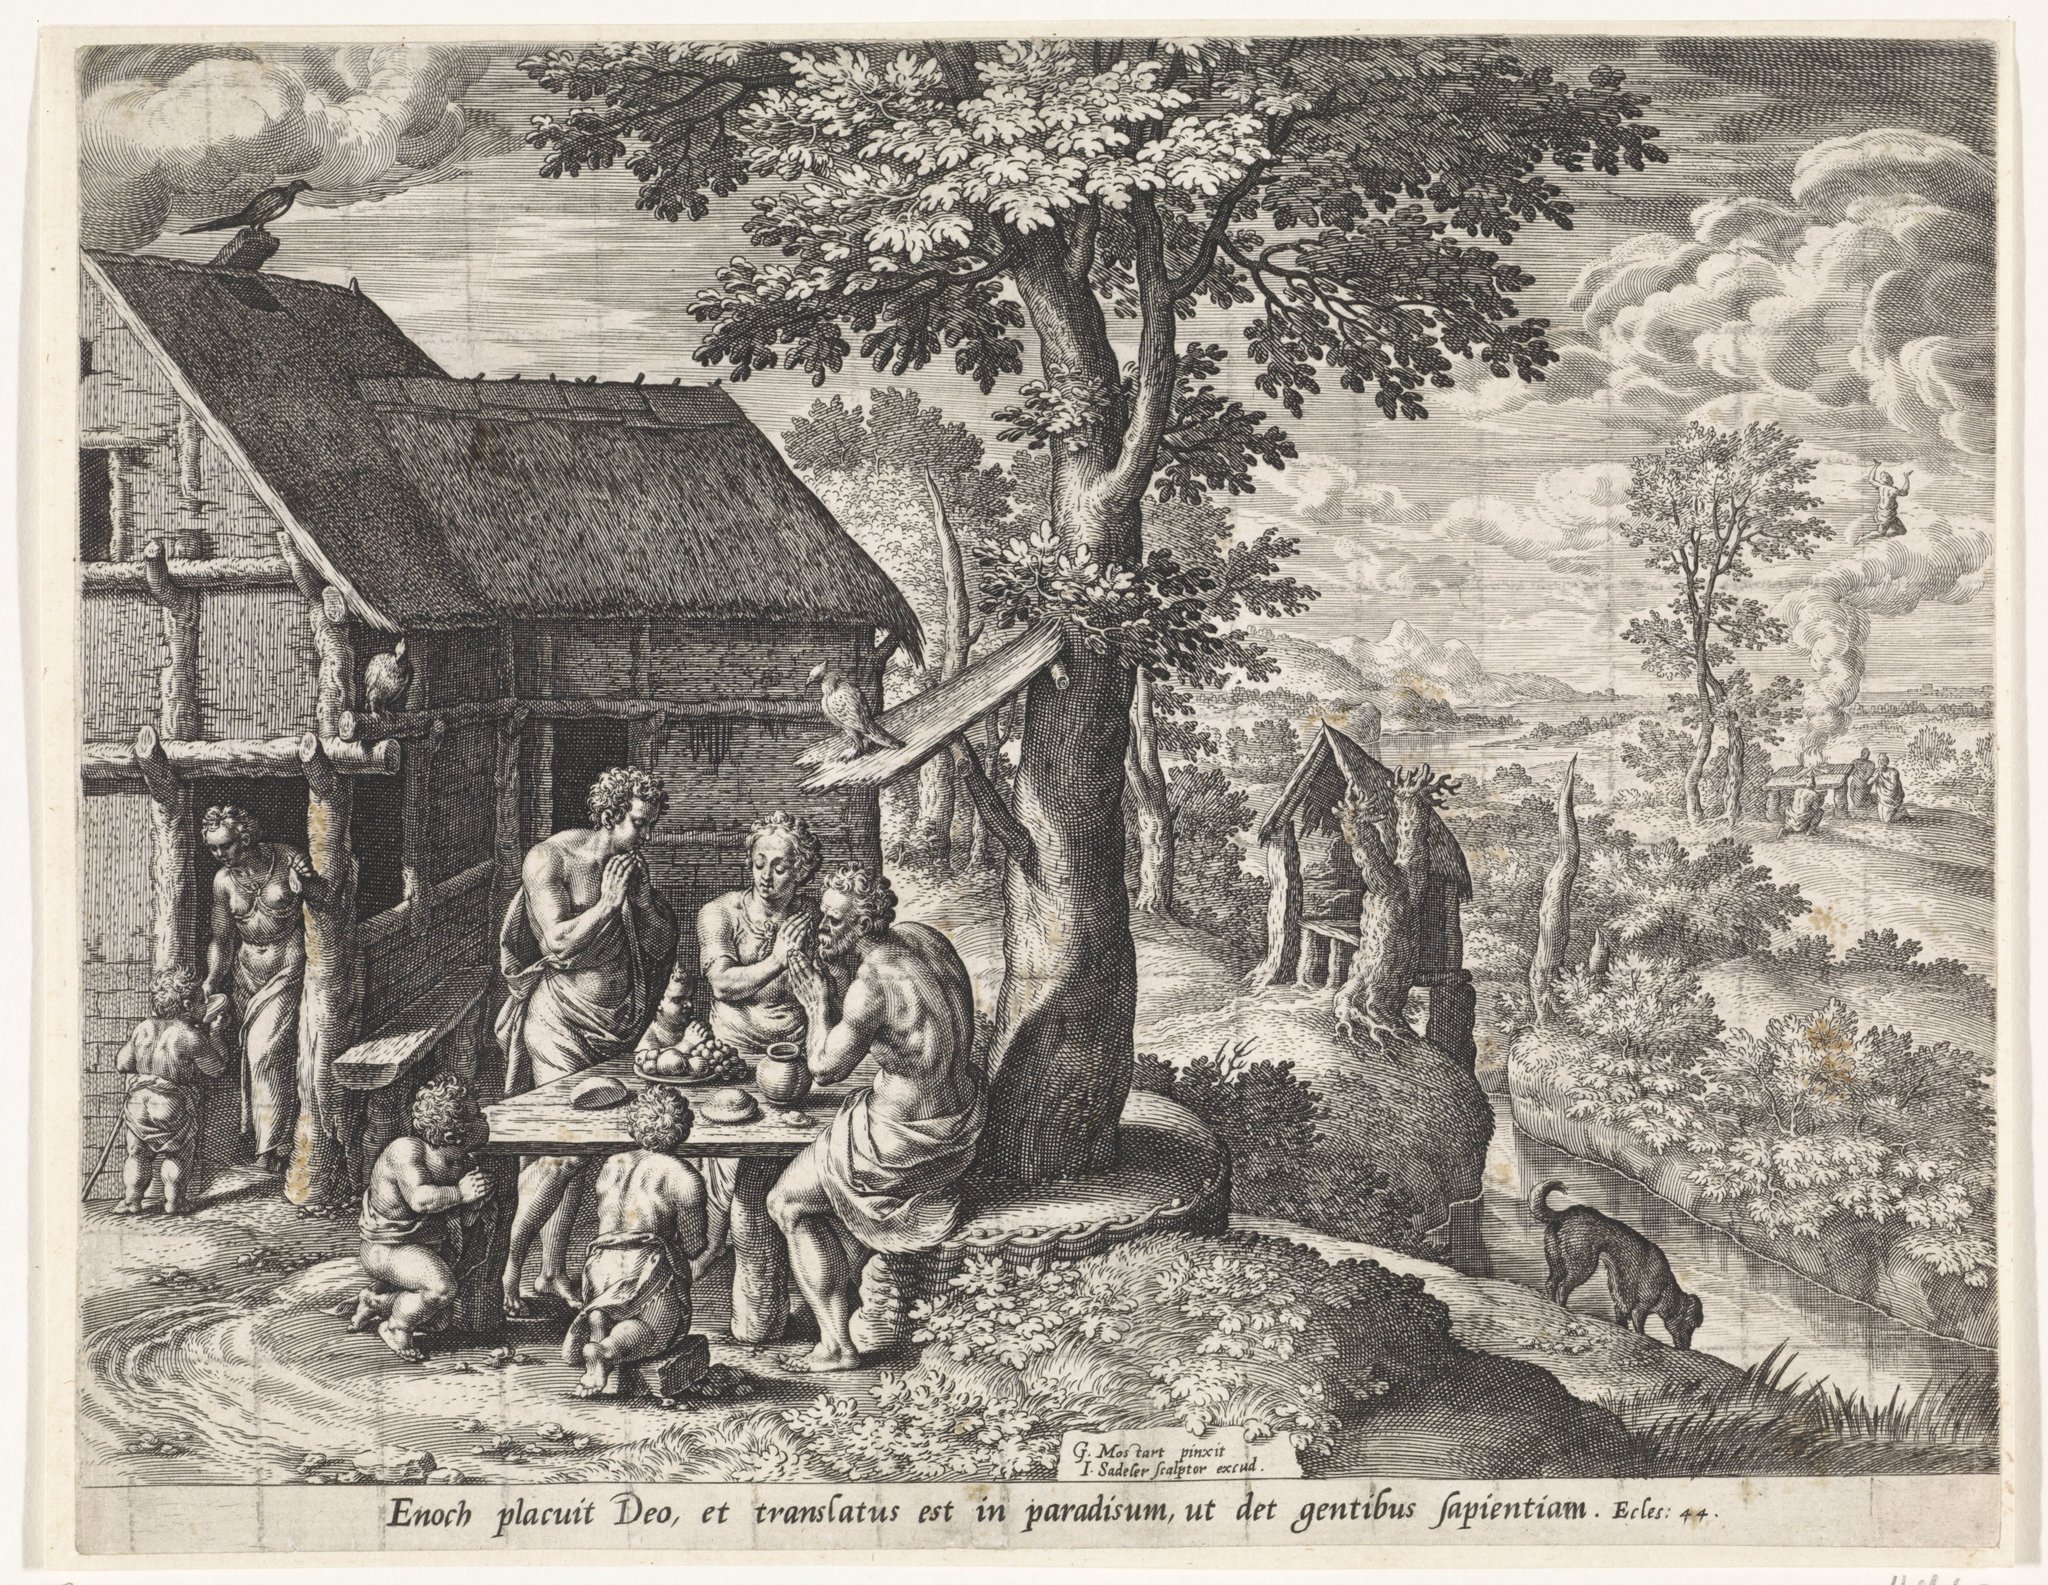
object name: print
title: Henoch bidt met zijn gezin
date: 1560-1600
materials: paper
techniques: engraving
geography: antwerp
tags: story of enoch, son of jared, who invented letters and was the first to divide the year into seasons and into twelve months, 'enoch ... was taken up' ~ enoch's translation, prayer at table, saying grace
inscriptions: collector's mark: Lugt 240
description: Henoch zit met zijn gezin aan tafel voor zijn huis. Het gezin bidt voor het eten tot God. In de deuropening van het huis een vrouw en een kind. Op de achtergrond een glooiend rivierlandschap met rechtsachter de hemelvaart van Henoch. De prent heeft een Latijns onderschrift.